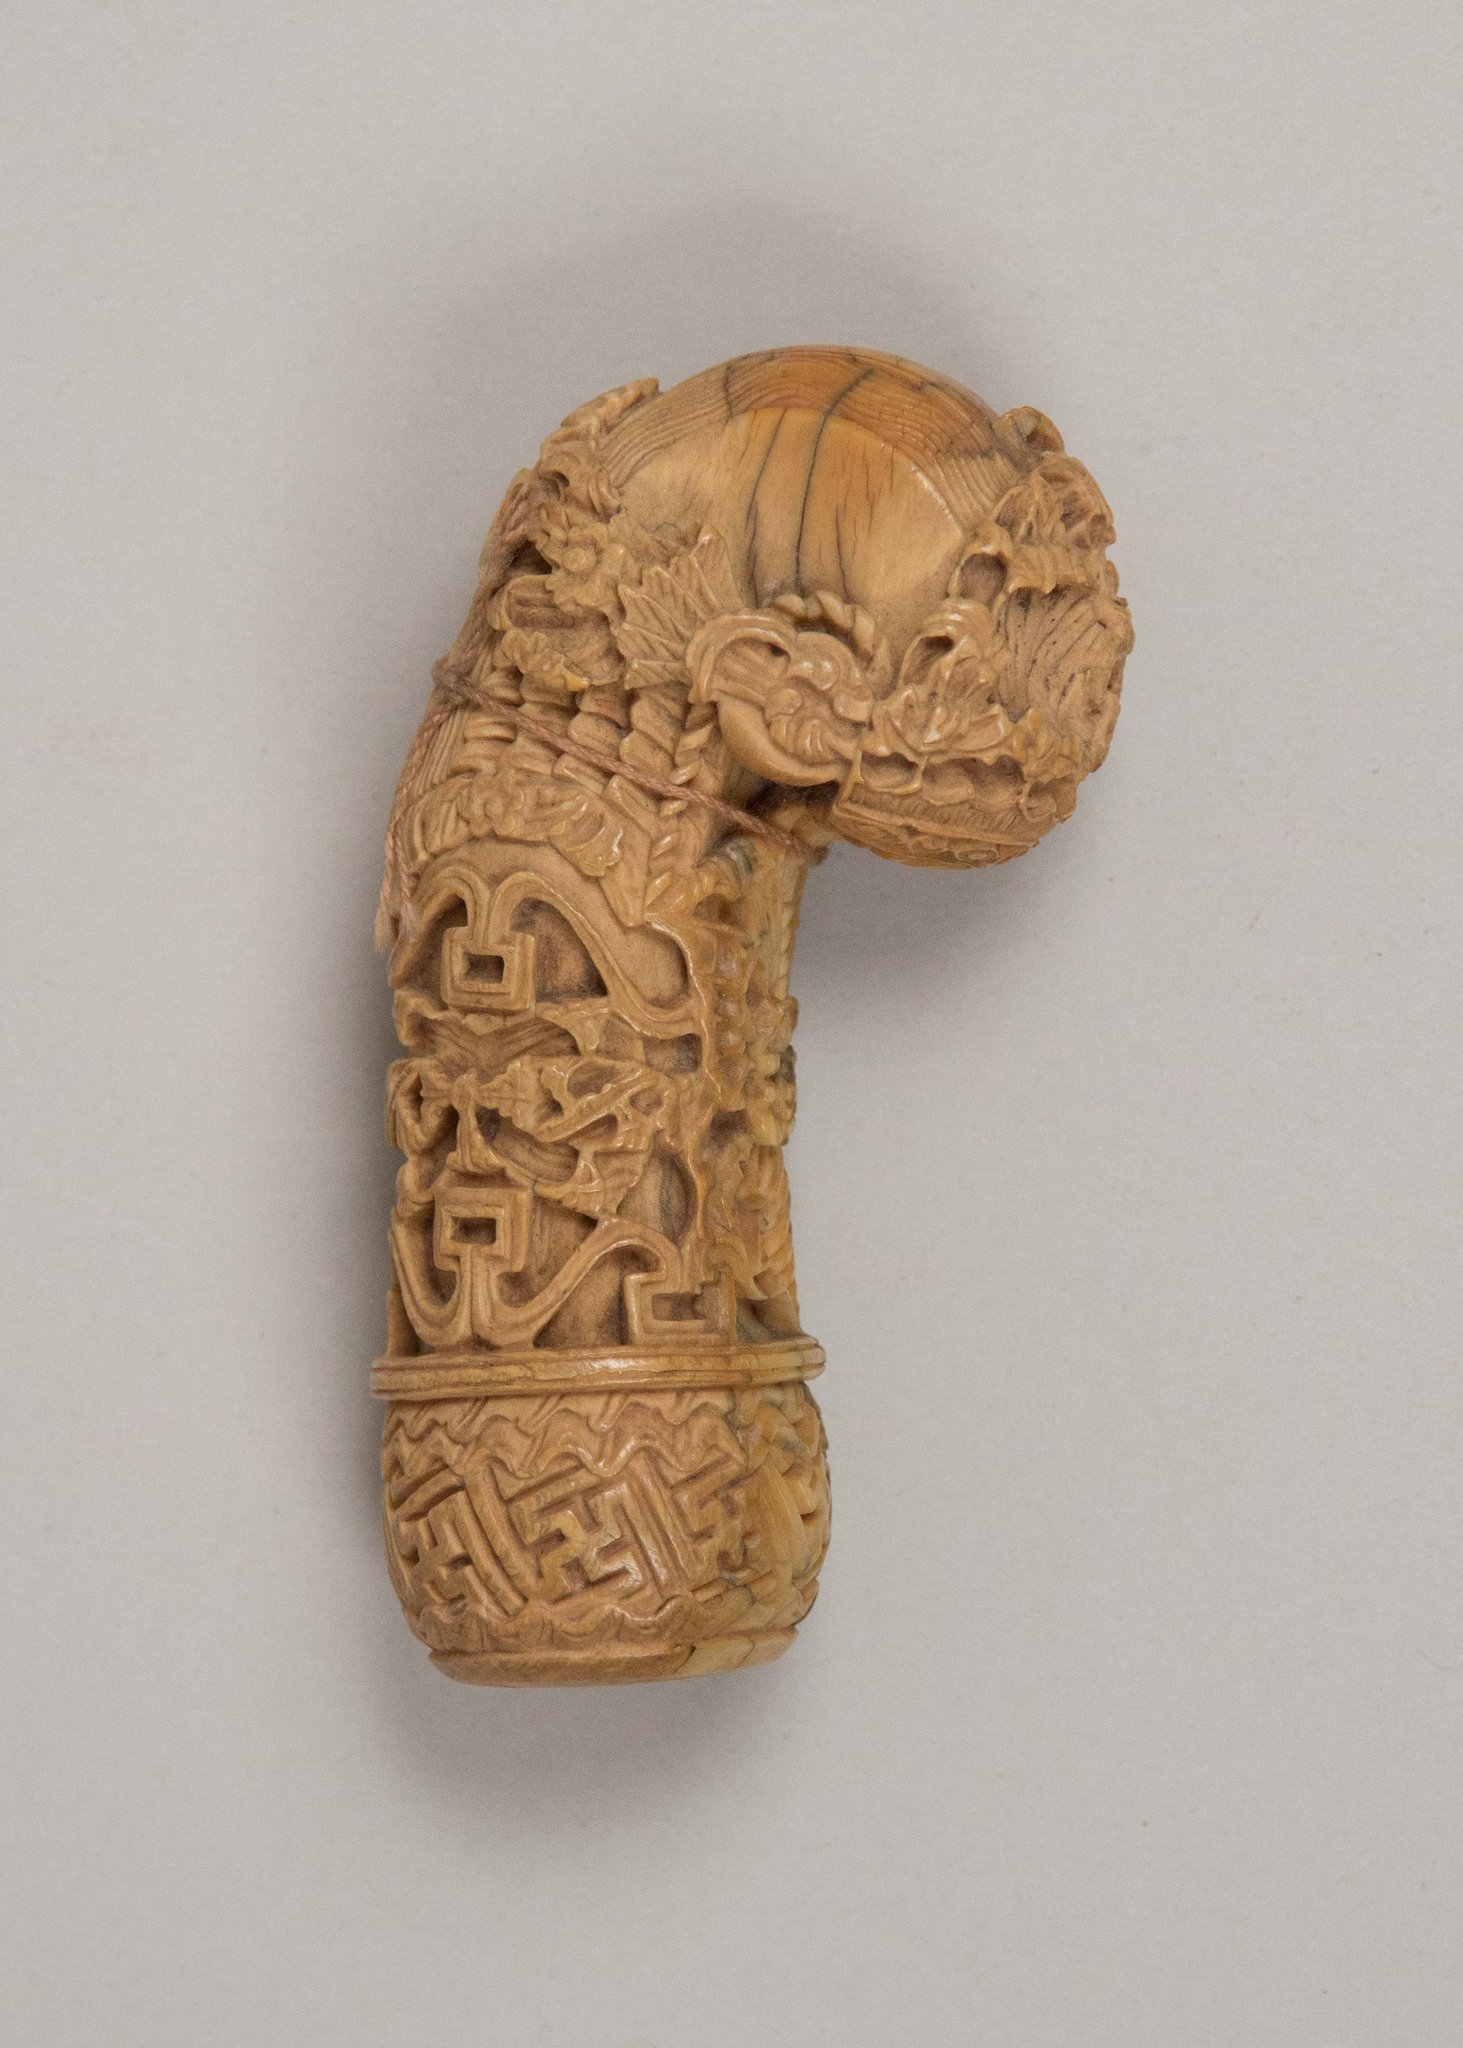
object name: kris hilt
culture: javanese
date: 1501-1900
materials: wood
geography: indonesia